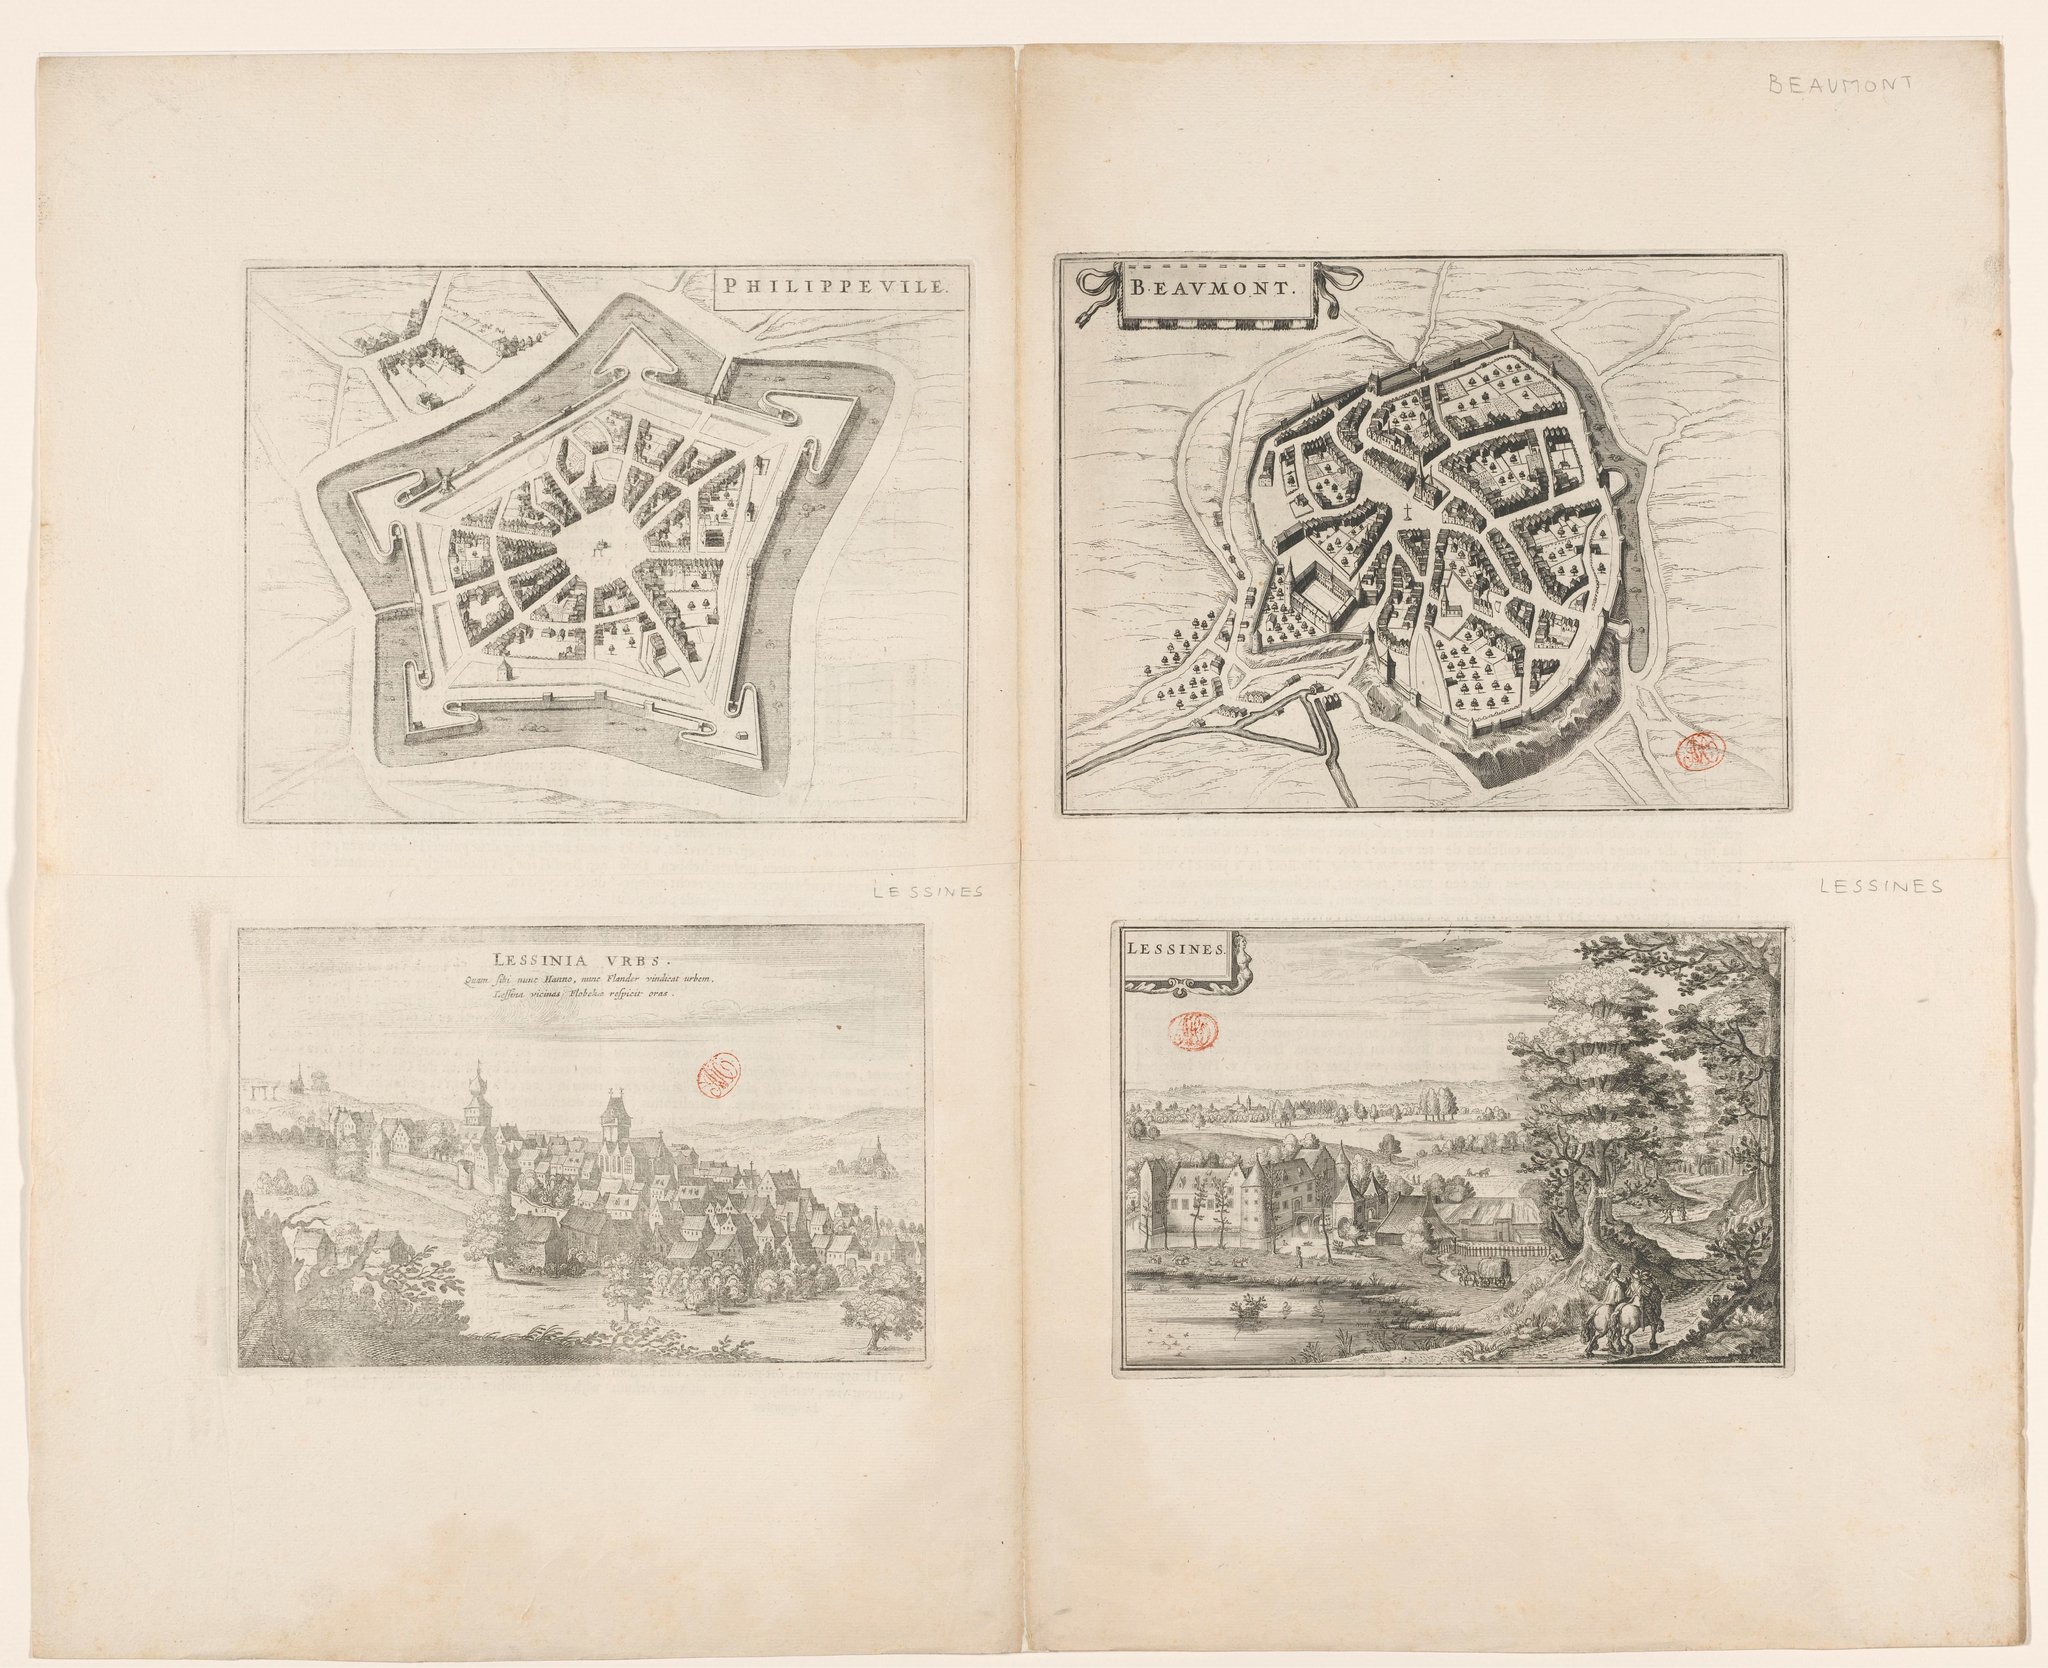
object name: area plan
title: Plattegrond van Philippeville en Beaumont en een gezicht op het Kasteel van l'Estriverie en de stad Lessen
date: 1652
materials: paper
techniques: engraving, etching, letterpress printing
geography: amsterdam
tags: prospect of village, silhouette of village, castle, fortified city, maps of cities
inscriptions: collector's mark: Lugt 195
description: Linksboven een plattegrond van Philippeville in vogelvluchtperspectief, met rechtsboven de titel in een kader. Rechtsboven een plattegrond van Beaumont in vogelvluchtperspectief, met linksboven de titelcartouche. Rechtsonder een gezicht op het Kasteel van l'Estriverie, met linksboven de titelcartouche. Op de voorgrond twee ruiters op een pad door het bos. Linksonder een gezicht op de stad Lessen, met boven de titel. Met Nederlandse tekst op verso.